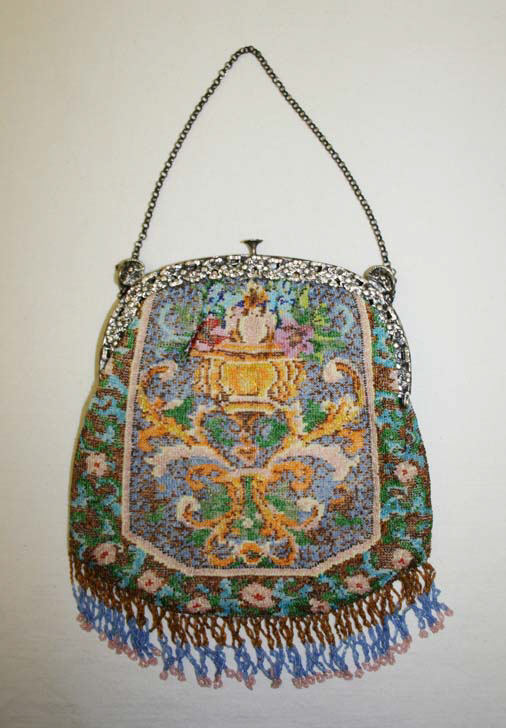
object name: bag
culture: french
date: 1867-1900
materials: silver